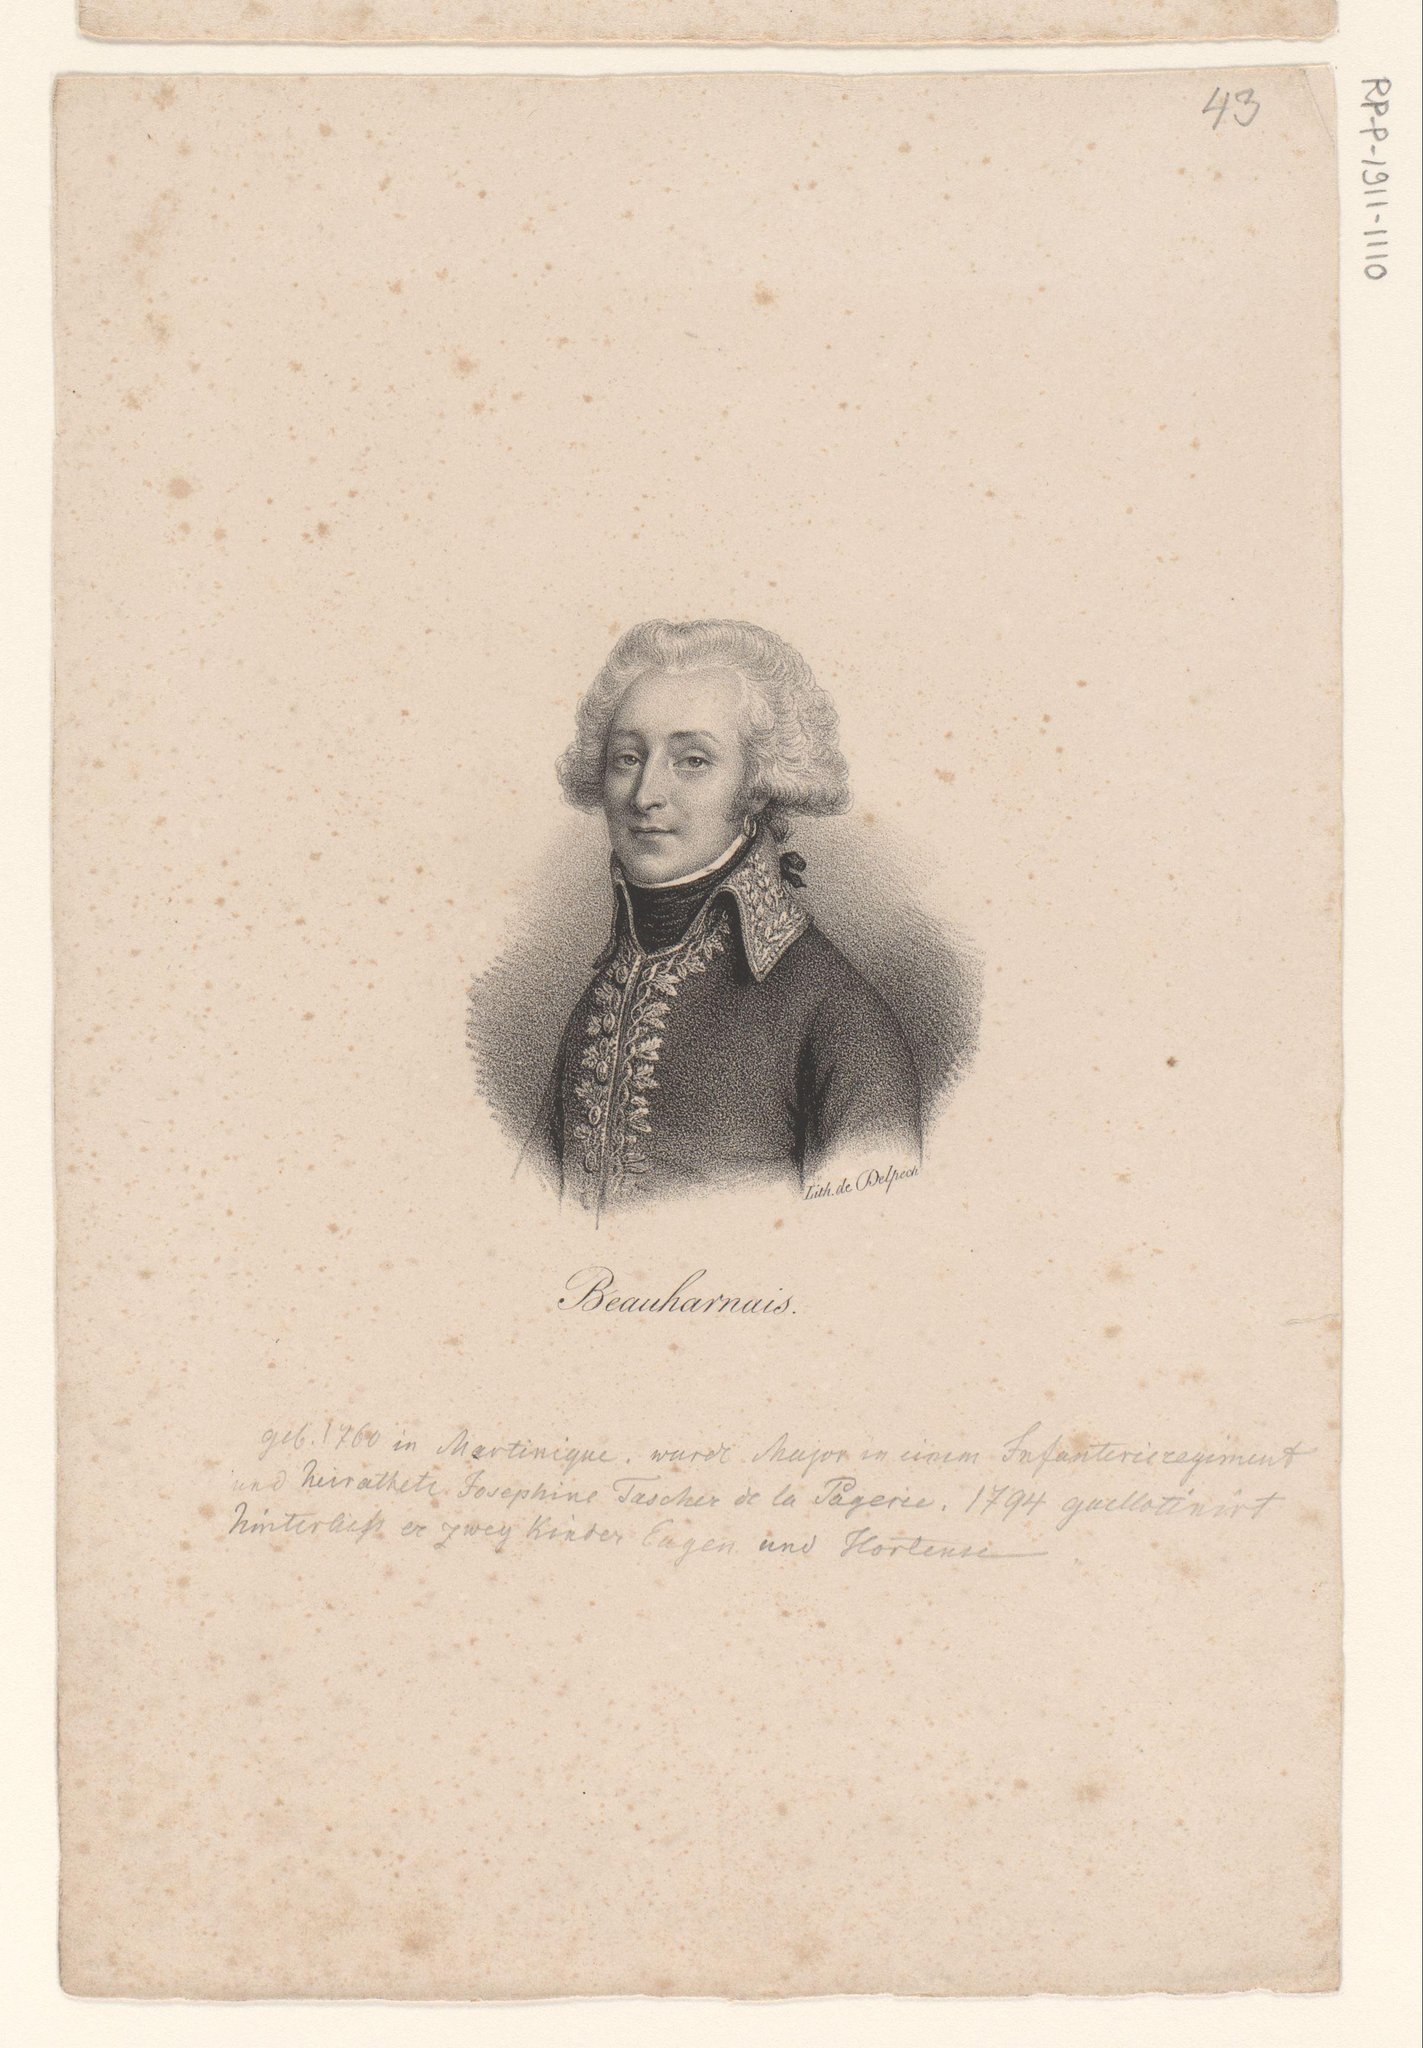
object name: print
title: Portret van Alexandre de Beauharnais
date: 1818-1842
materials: paper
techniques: lithograph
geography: paris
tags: paris, historical persons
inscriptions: collector's mark: Lugt 2228a